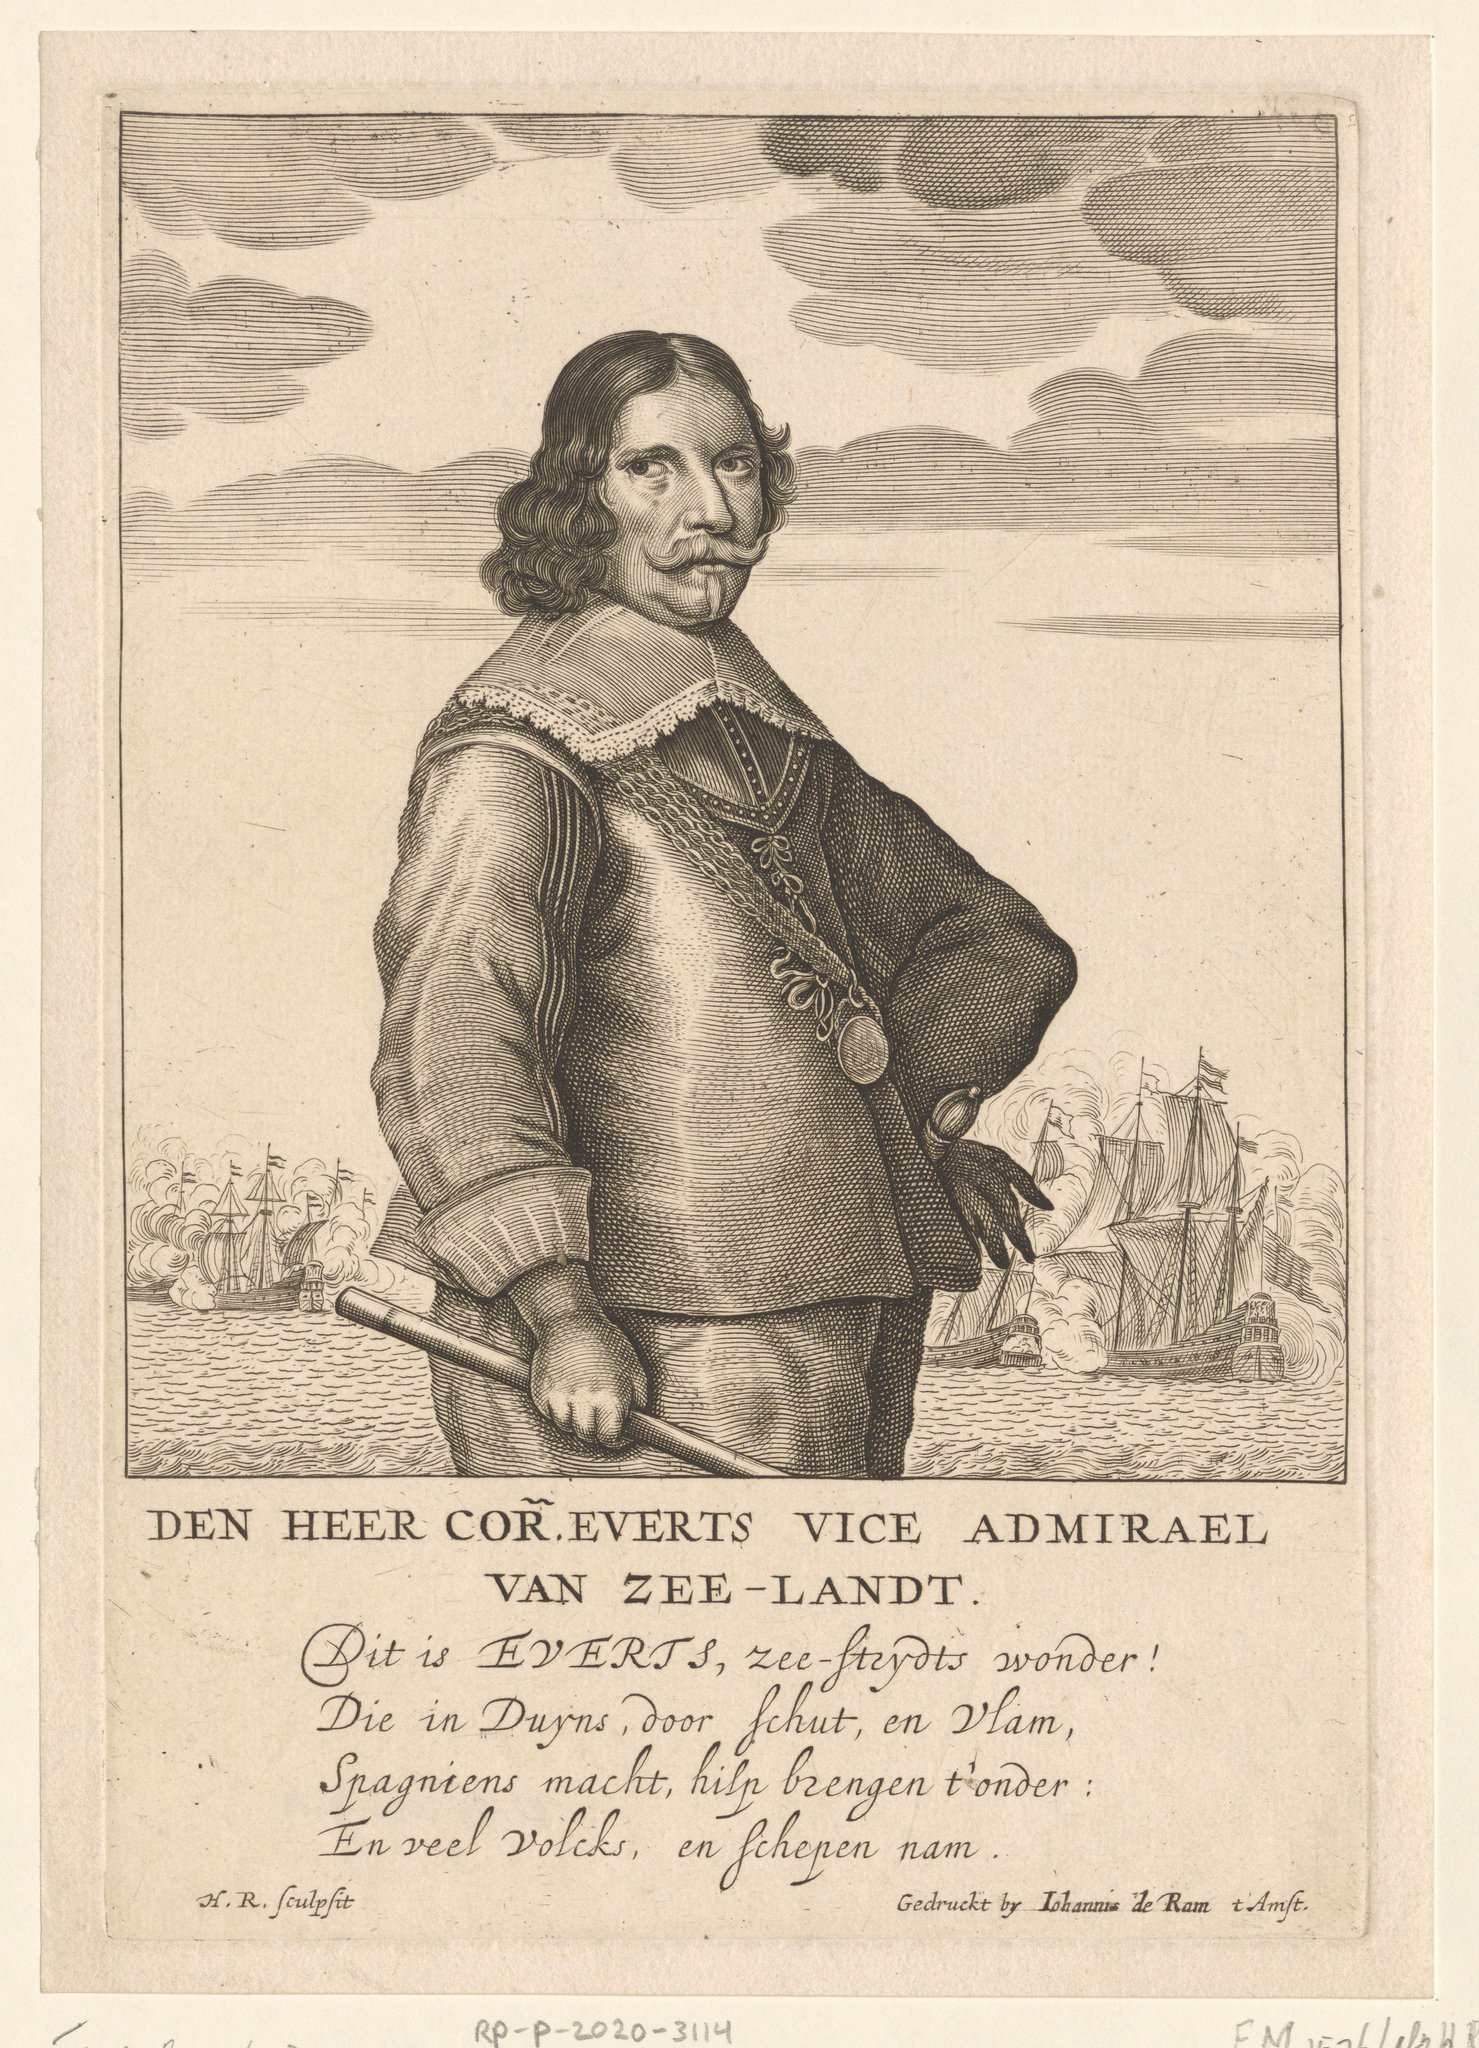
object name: print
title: Portret van Cornelis Evertsen (I)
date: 1643-1664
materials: paper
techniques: engraving, etching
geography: amsterdam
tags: battle (+ naval force), historical persons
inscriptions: collector's mark: Lugt 2228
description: Met vierregelig vers in het Nederlands onder het portret.